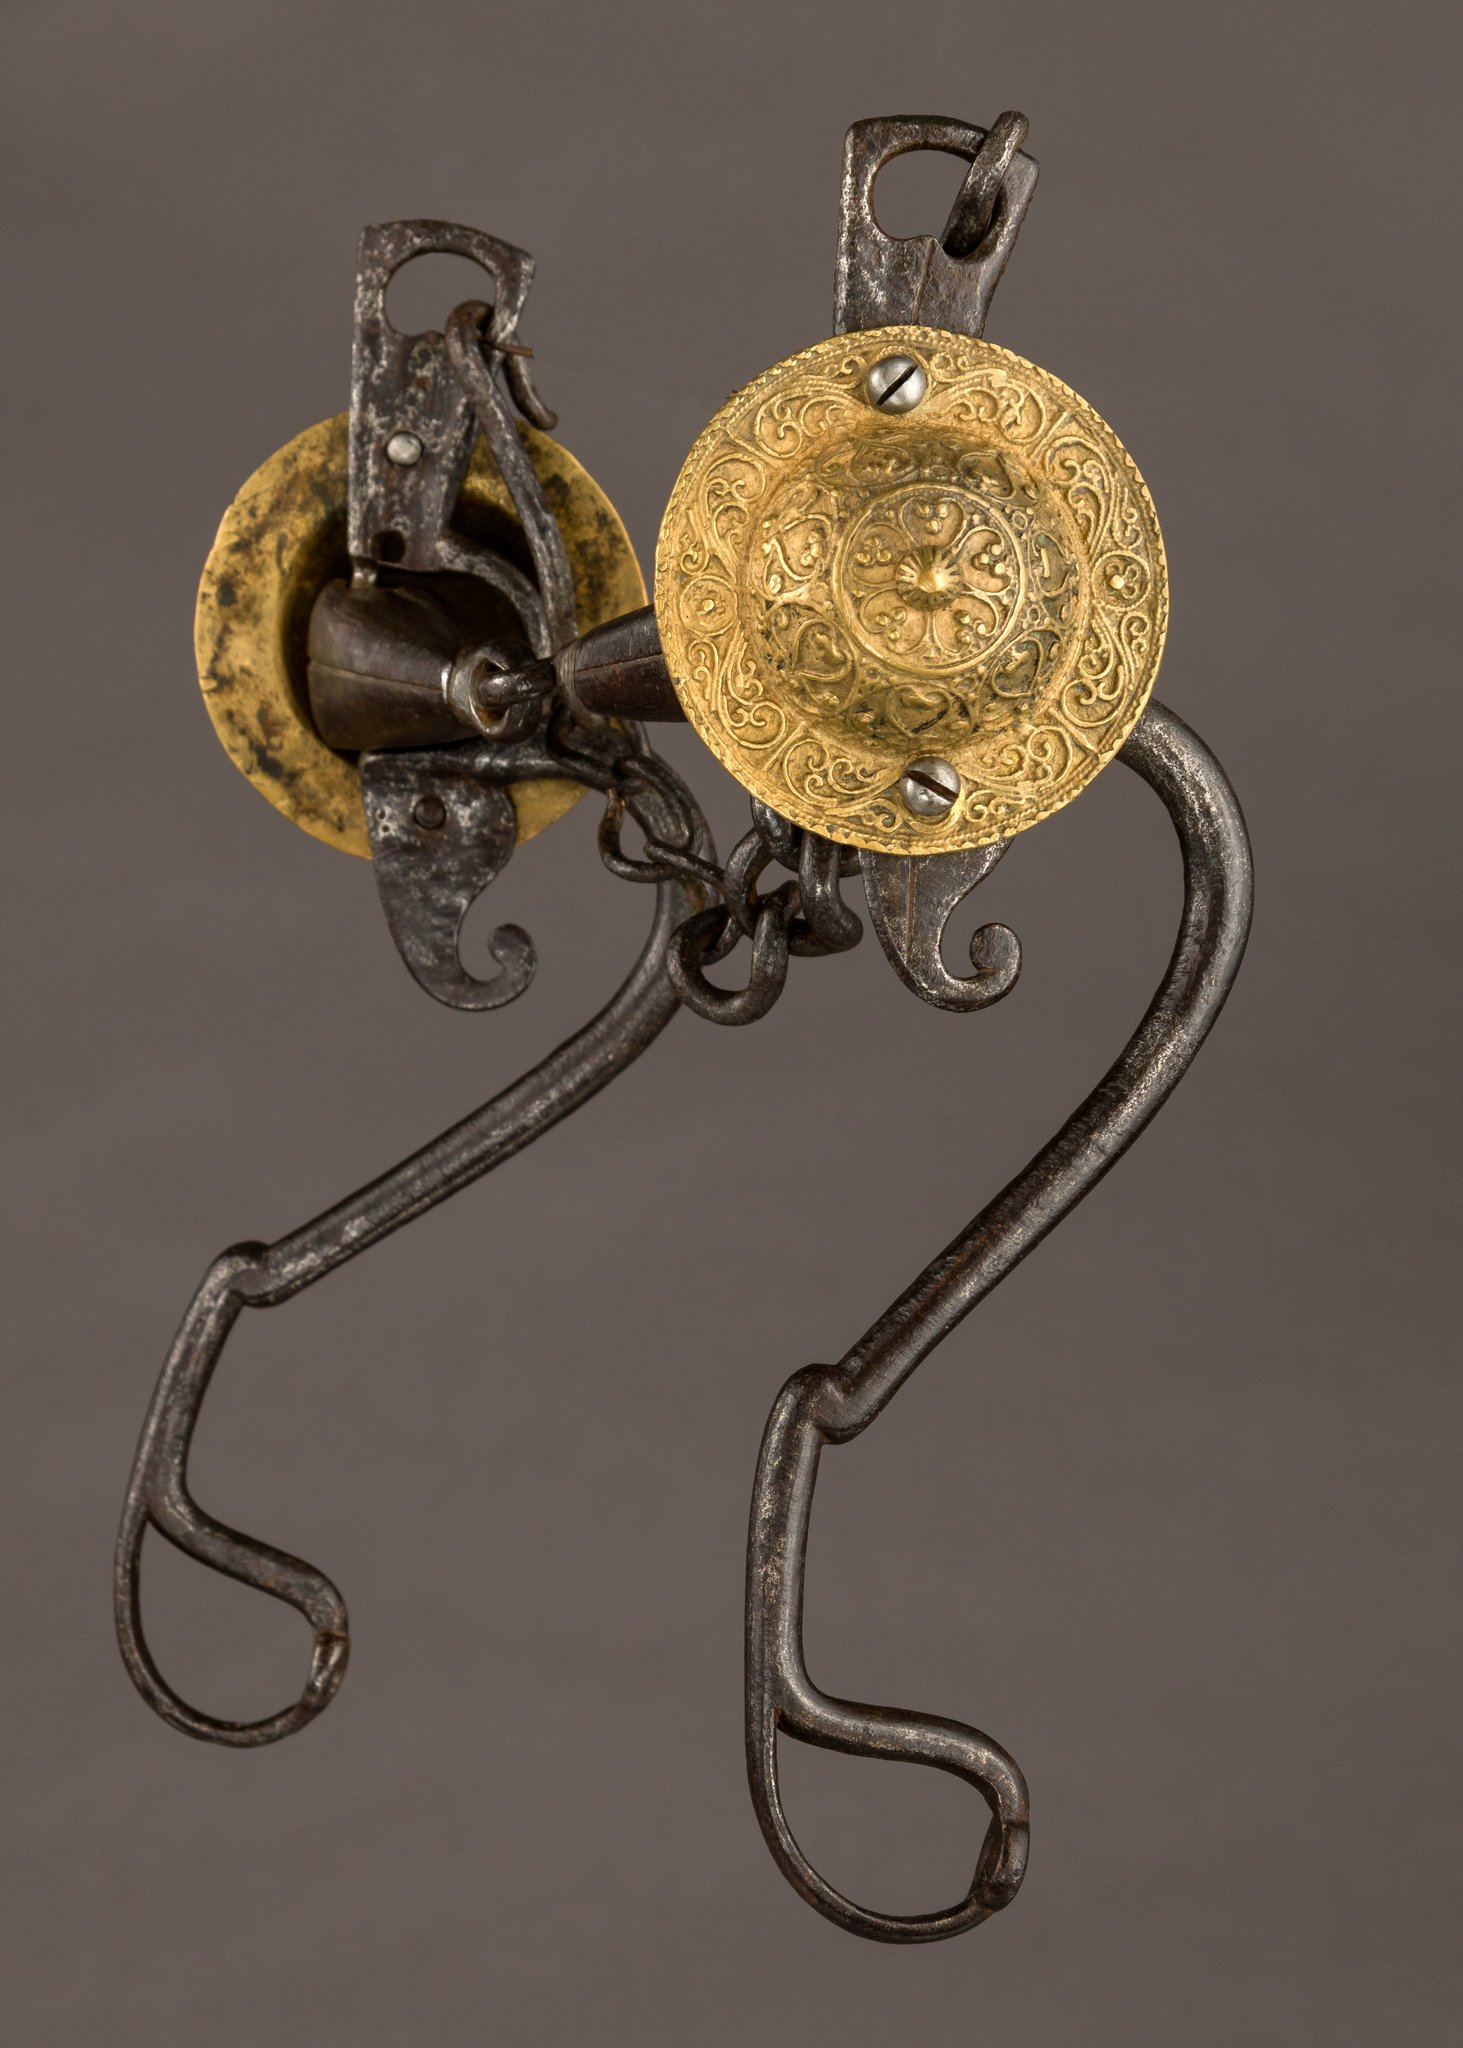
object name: bit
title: Curb Bit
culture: bit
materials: copper alloy, gold, metal alloy, tin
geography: italy